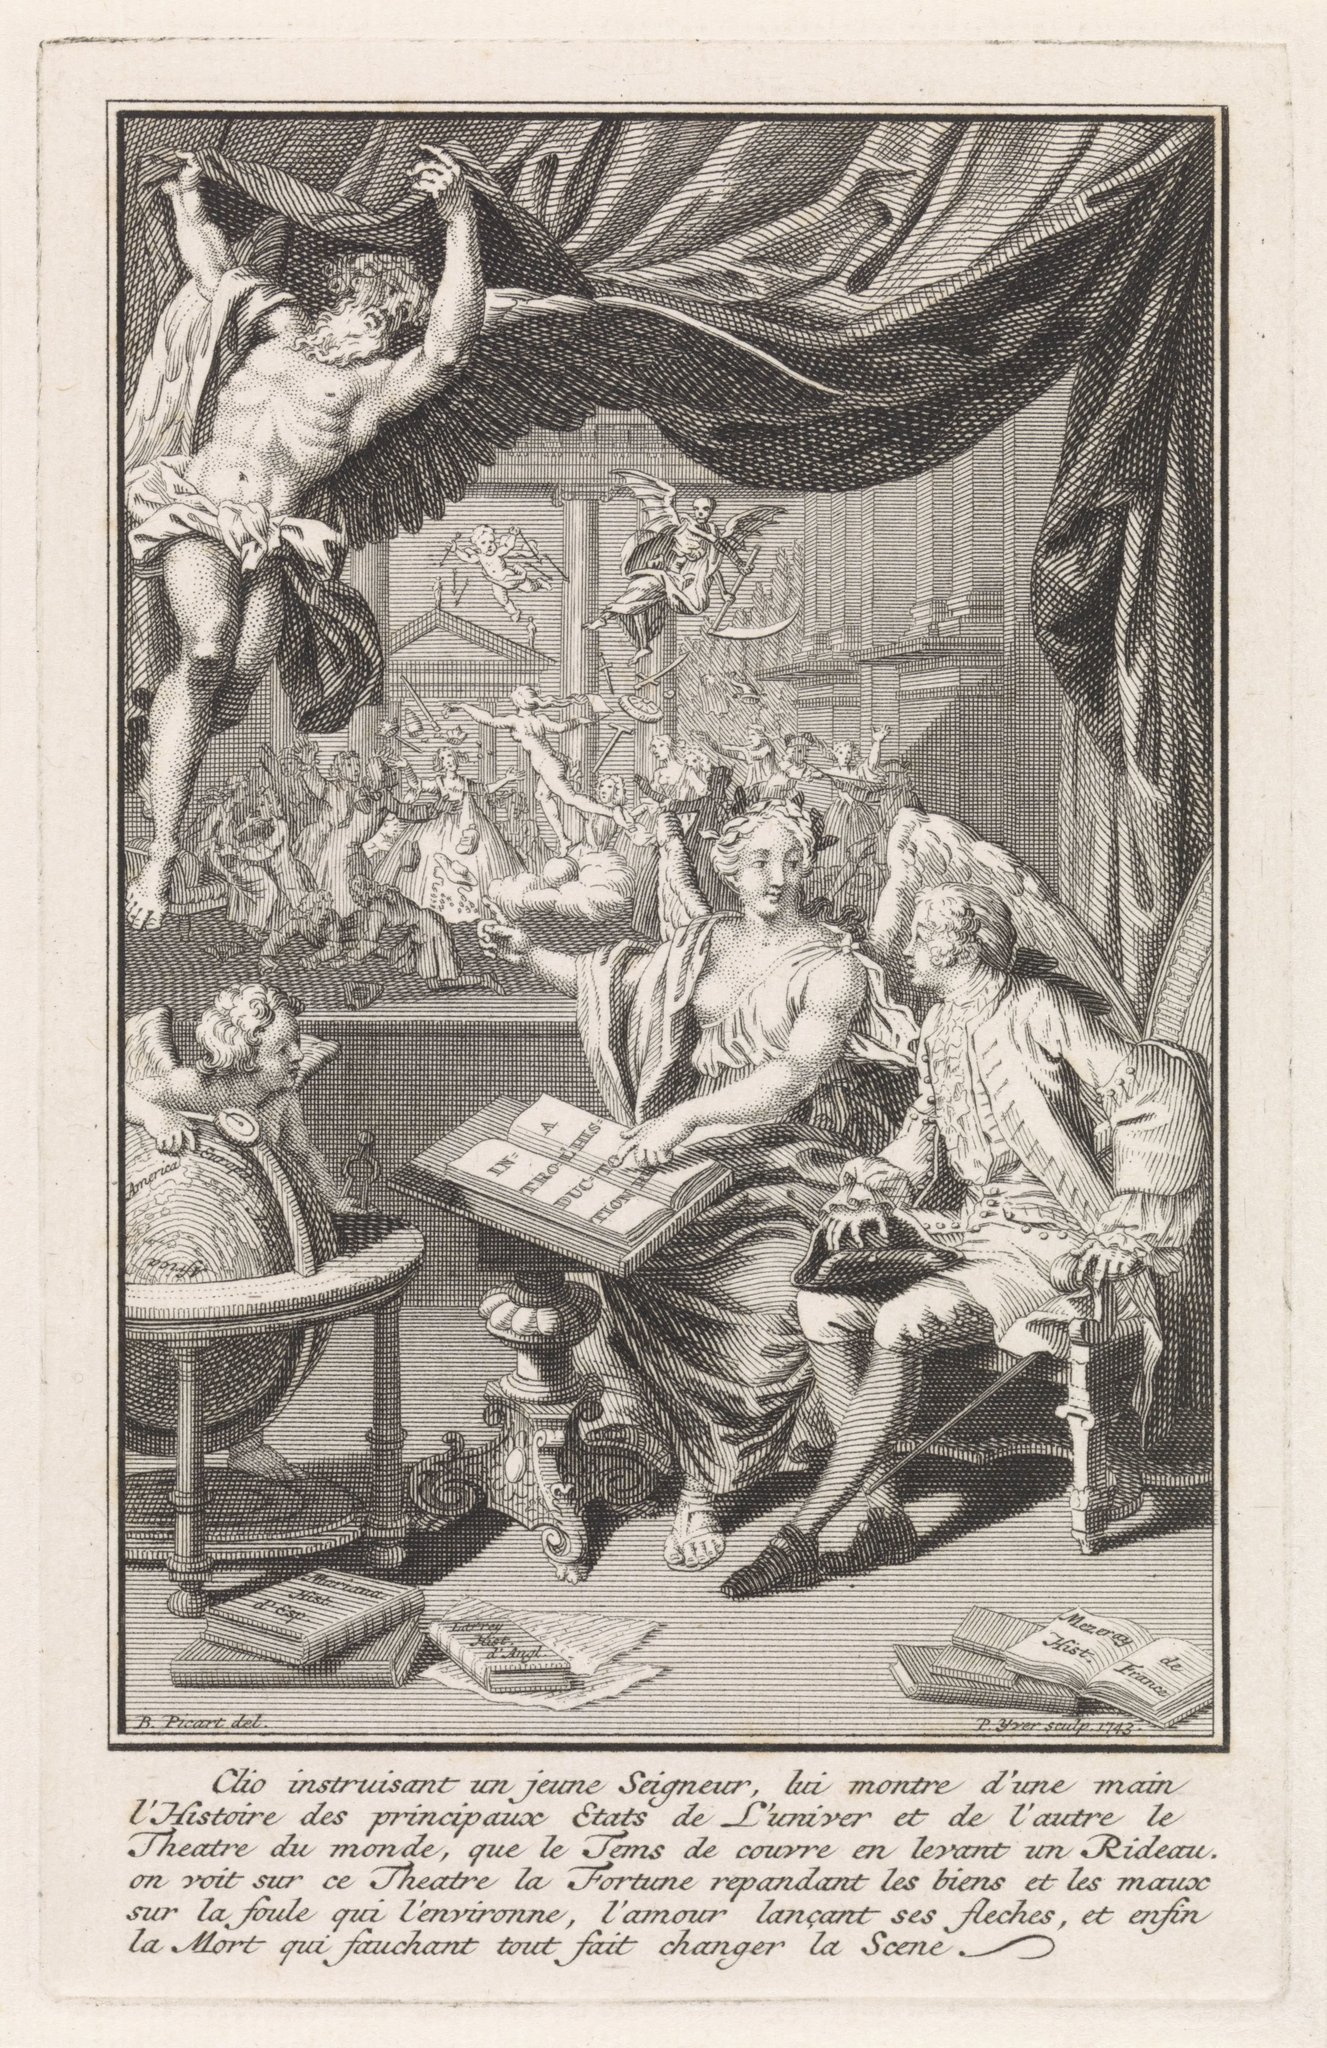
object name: print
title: Clio onderwijst een jonge man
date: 1743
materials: paper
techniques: engraving, etching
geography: amsterdam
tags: luck, fortune, lot; 'fato', 'fortuna', 'fortuna aurea', 'fortuna buona', 'fortuna pacifica overo clemente', 'sorte' (ripa), 'historia'; 'historia' (ripa), clio (one of the muses); 'clio' (ripa), father time, man with wings and scythe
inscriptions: collector's mark: Lugt 240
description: Clio, de muze van de geschiedenis, introduceert een jonge man in het vak van de geschiedenis. Zij wijst hem op het toneel van de geschiedenis, waarop Fortuna, staande op een globe, haar rijkdommen lukraak onder de mensen verdeeld. Daarboven zweeft de Dood met zijn zeis en Amor, die zijn pijlen laat vallen. Vader Tijd onthuld het toneel door het doek op te houden. Onderaan in de marge een zesregelige tekst in het Frans.